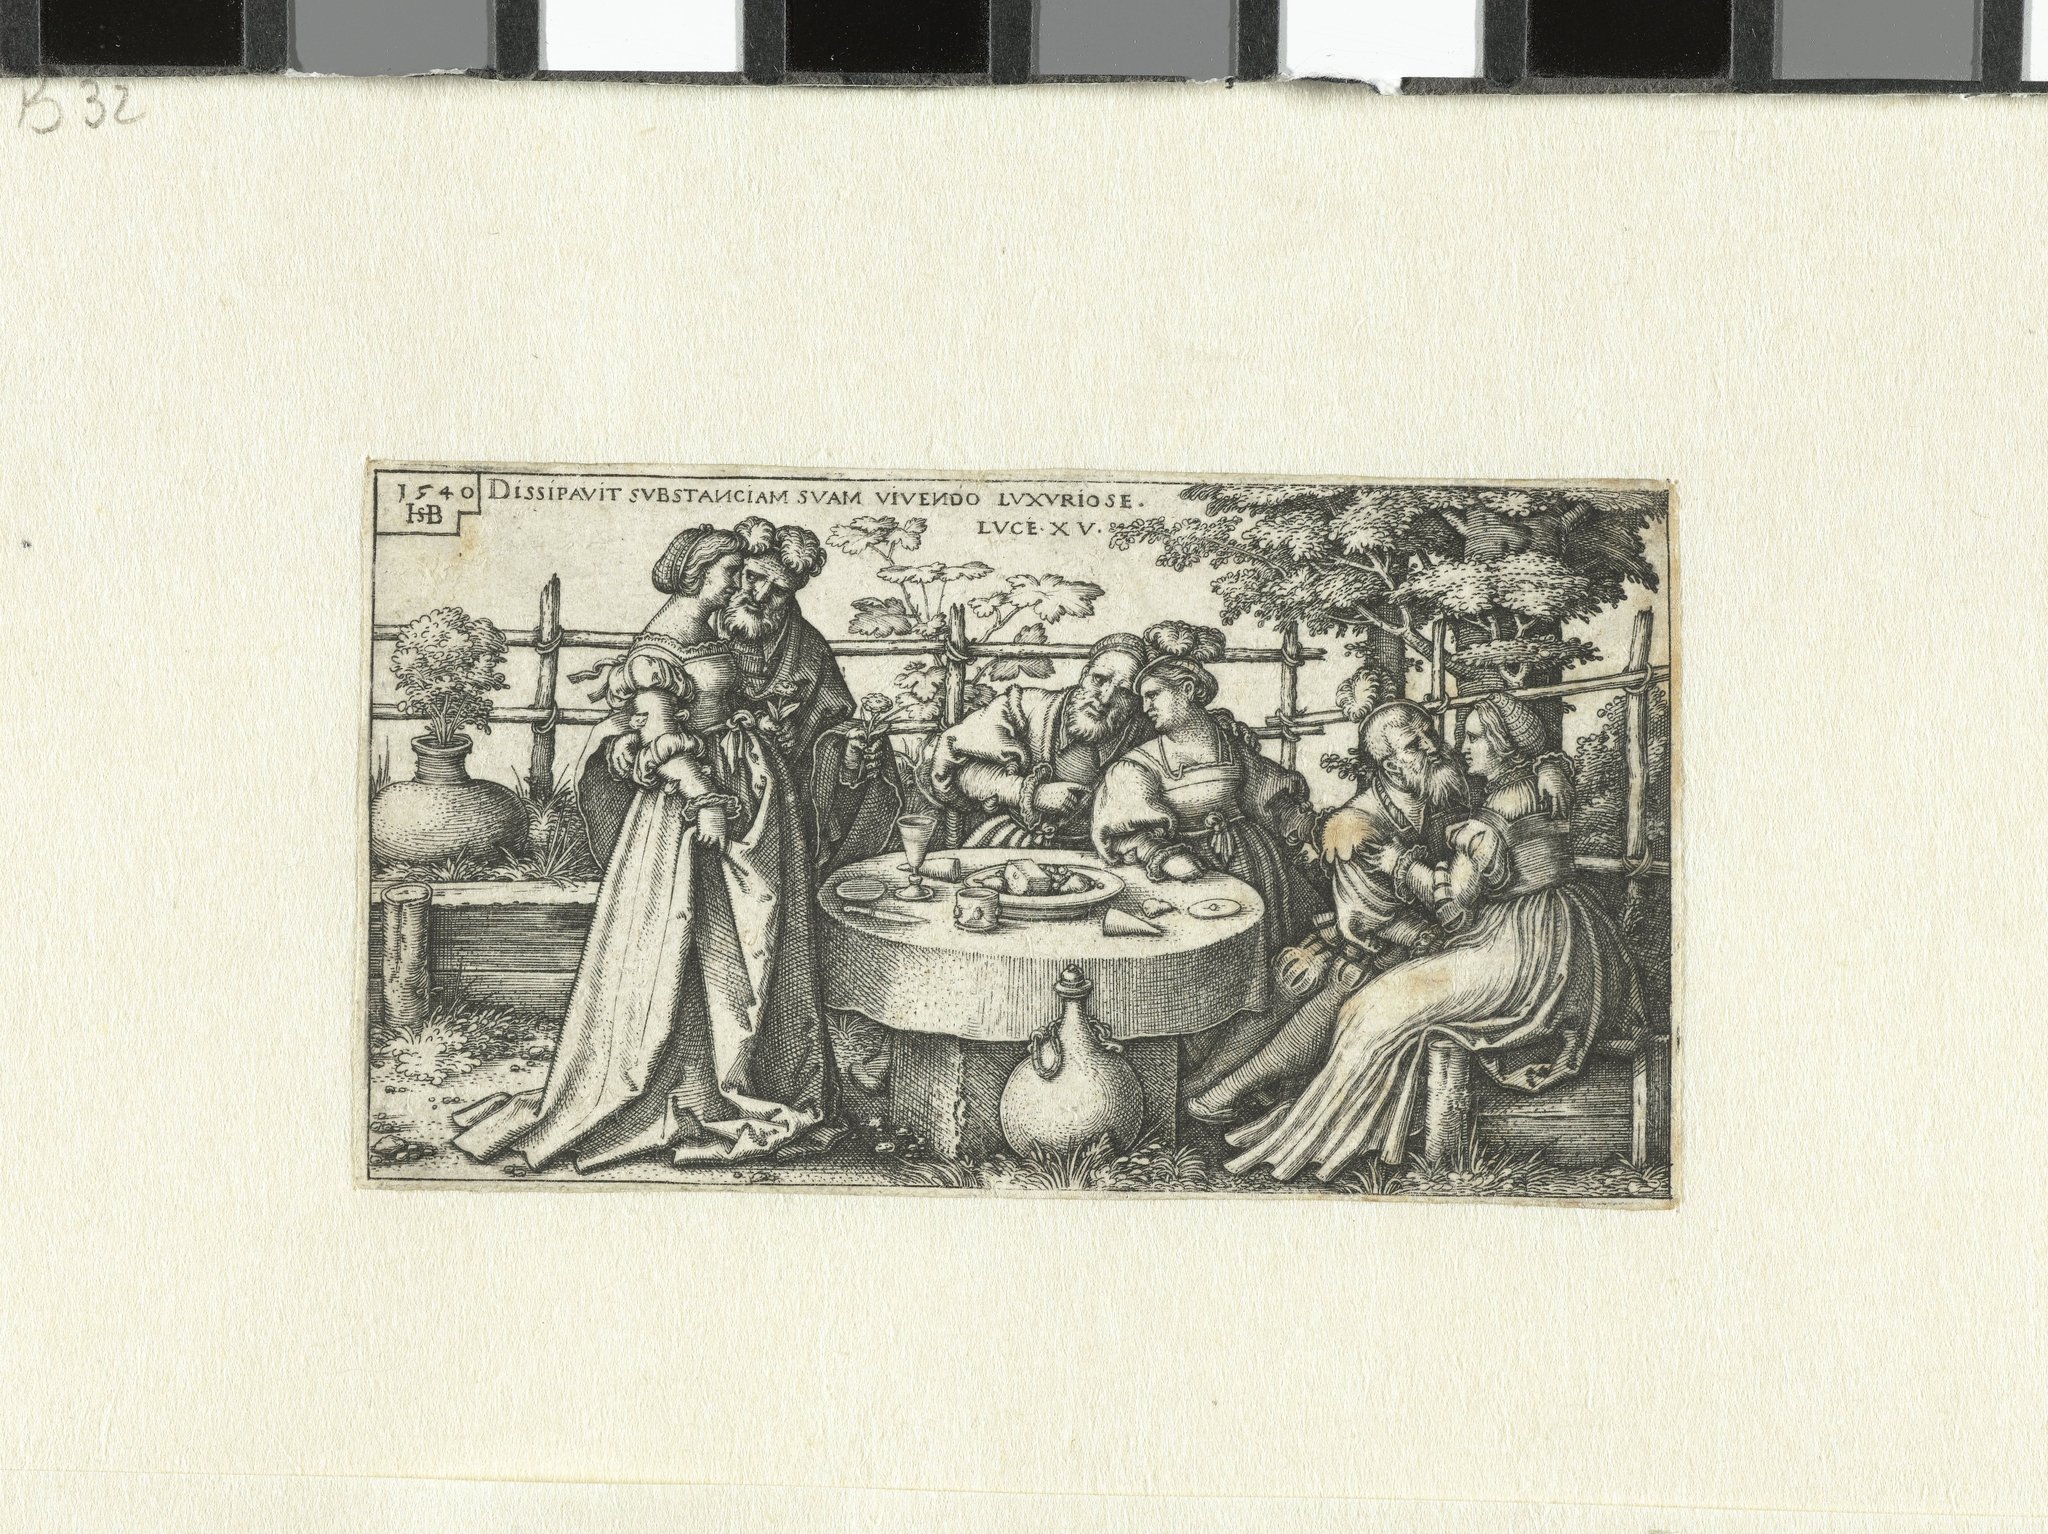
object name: print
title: Verhaal van de Verloren Zoon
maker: hans sebald beham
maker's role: designer, draughtsman, print maker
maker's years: 1500-1550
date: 1540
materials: paper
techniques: engraving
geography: frankfurt am main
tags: the prodigal son in the midst of prostitutes feasting and dissipating his patrimony, usually in a brothel or inn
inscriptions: date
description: Boven de voorstelling staat de Latijnse bijbeltekst DISSIPAVIT SVBSTANCIAM SVAM VIVENDO LVXVRIOSE LUCE XV